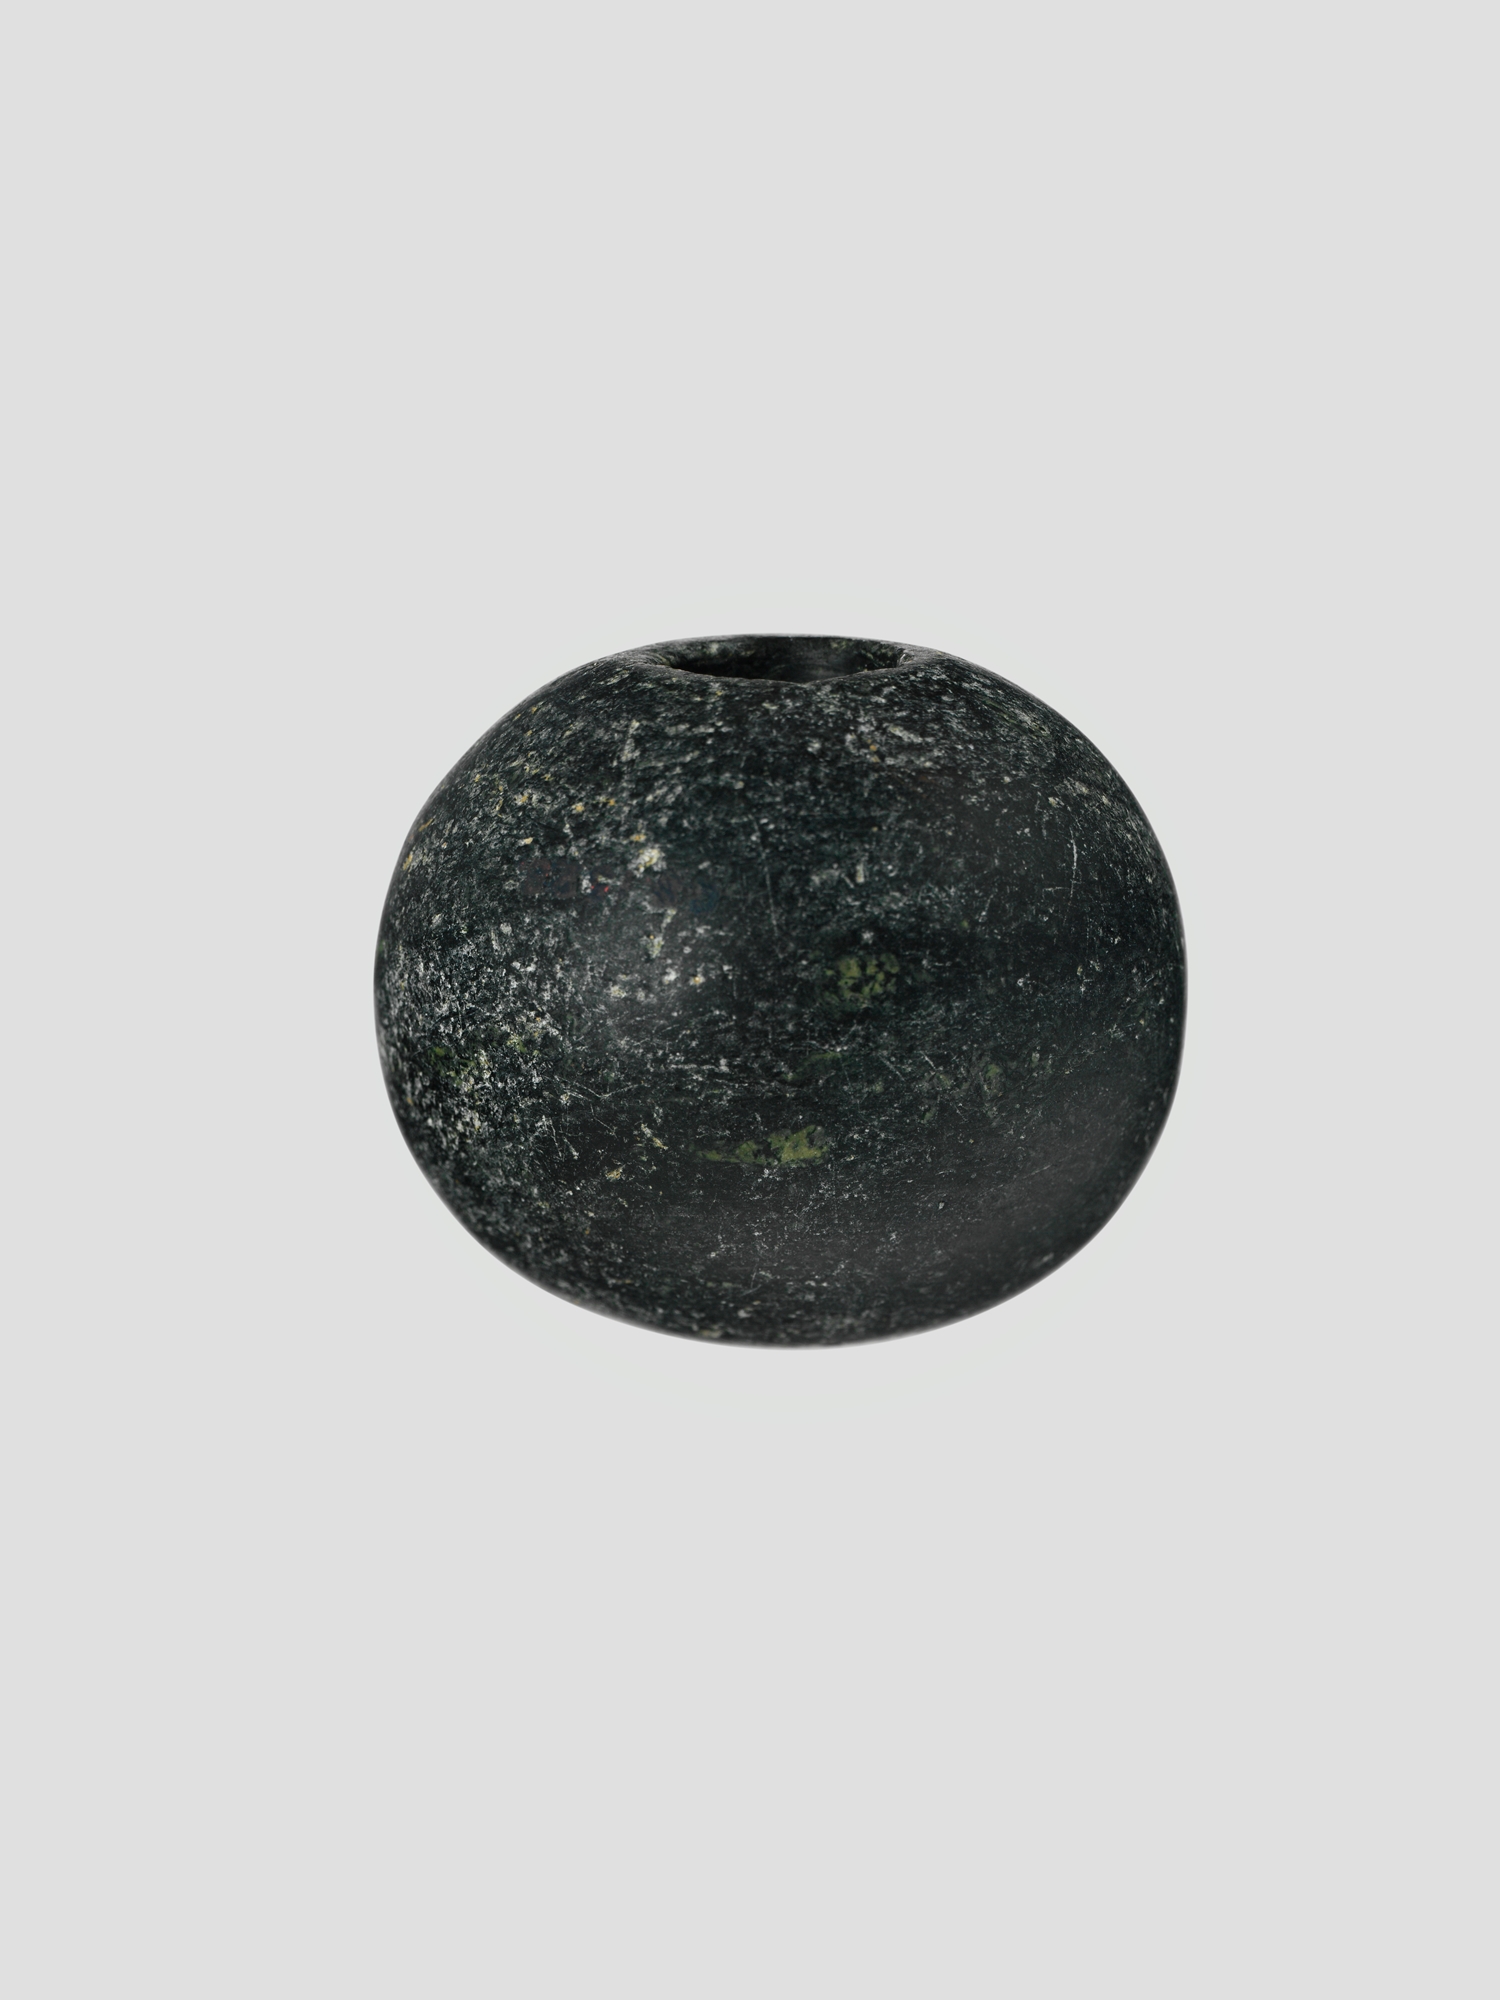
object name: mace head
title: Gabbro mace head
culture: cypriot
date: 2500-1900 BCE